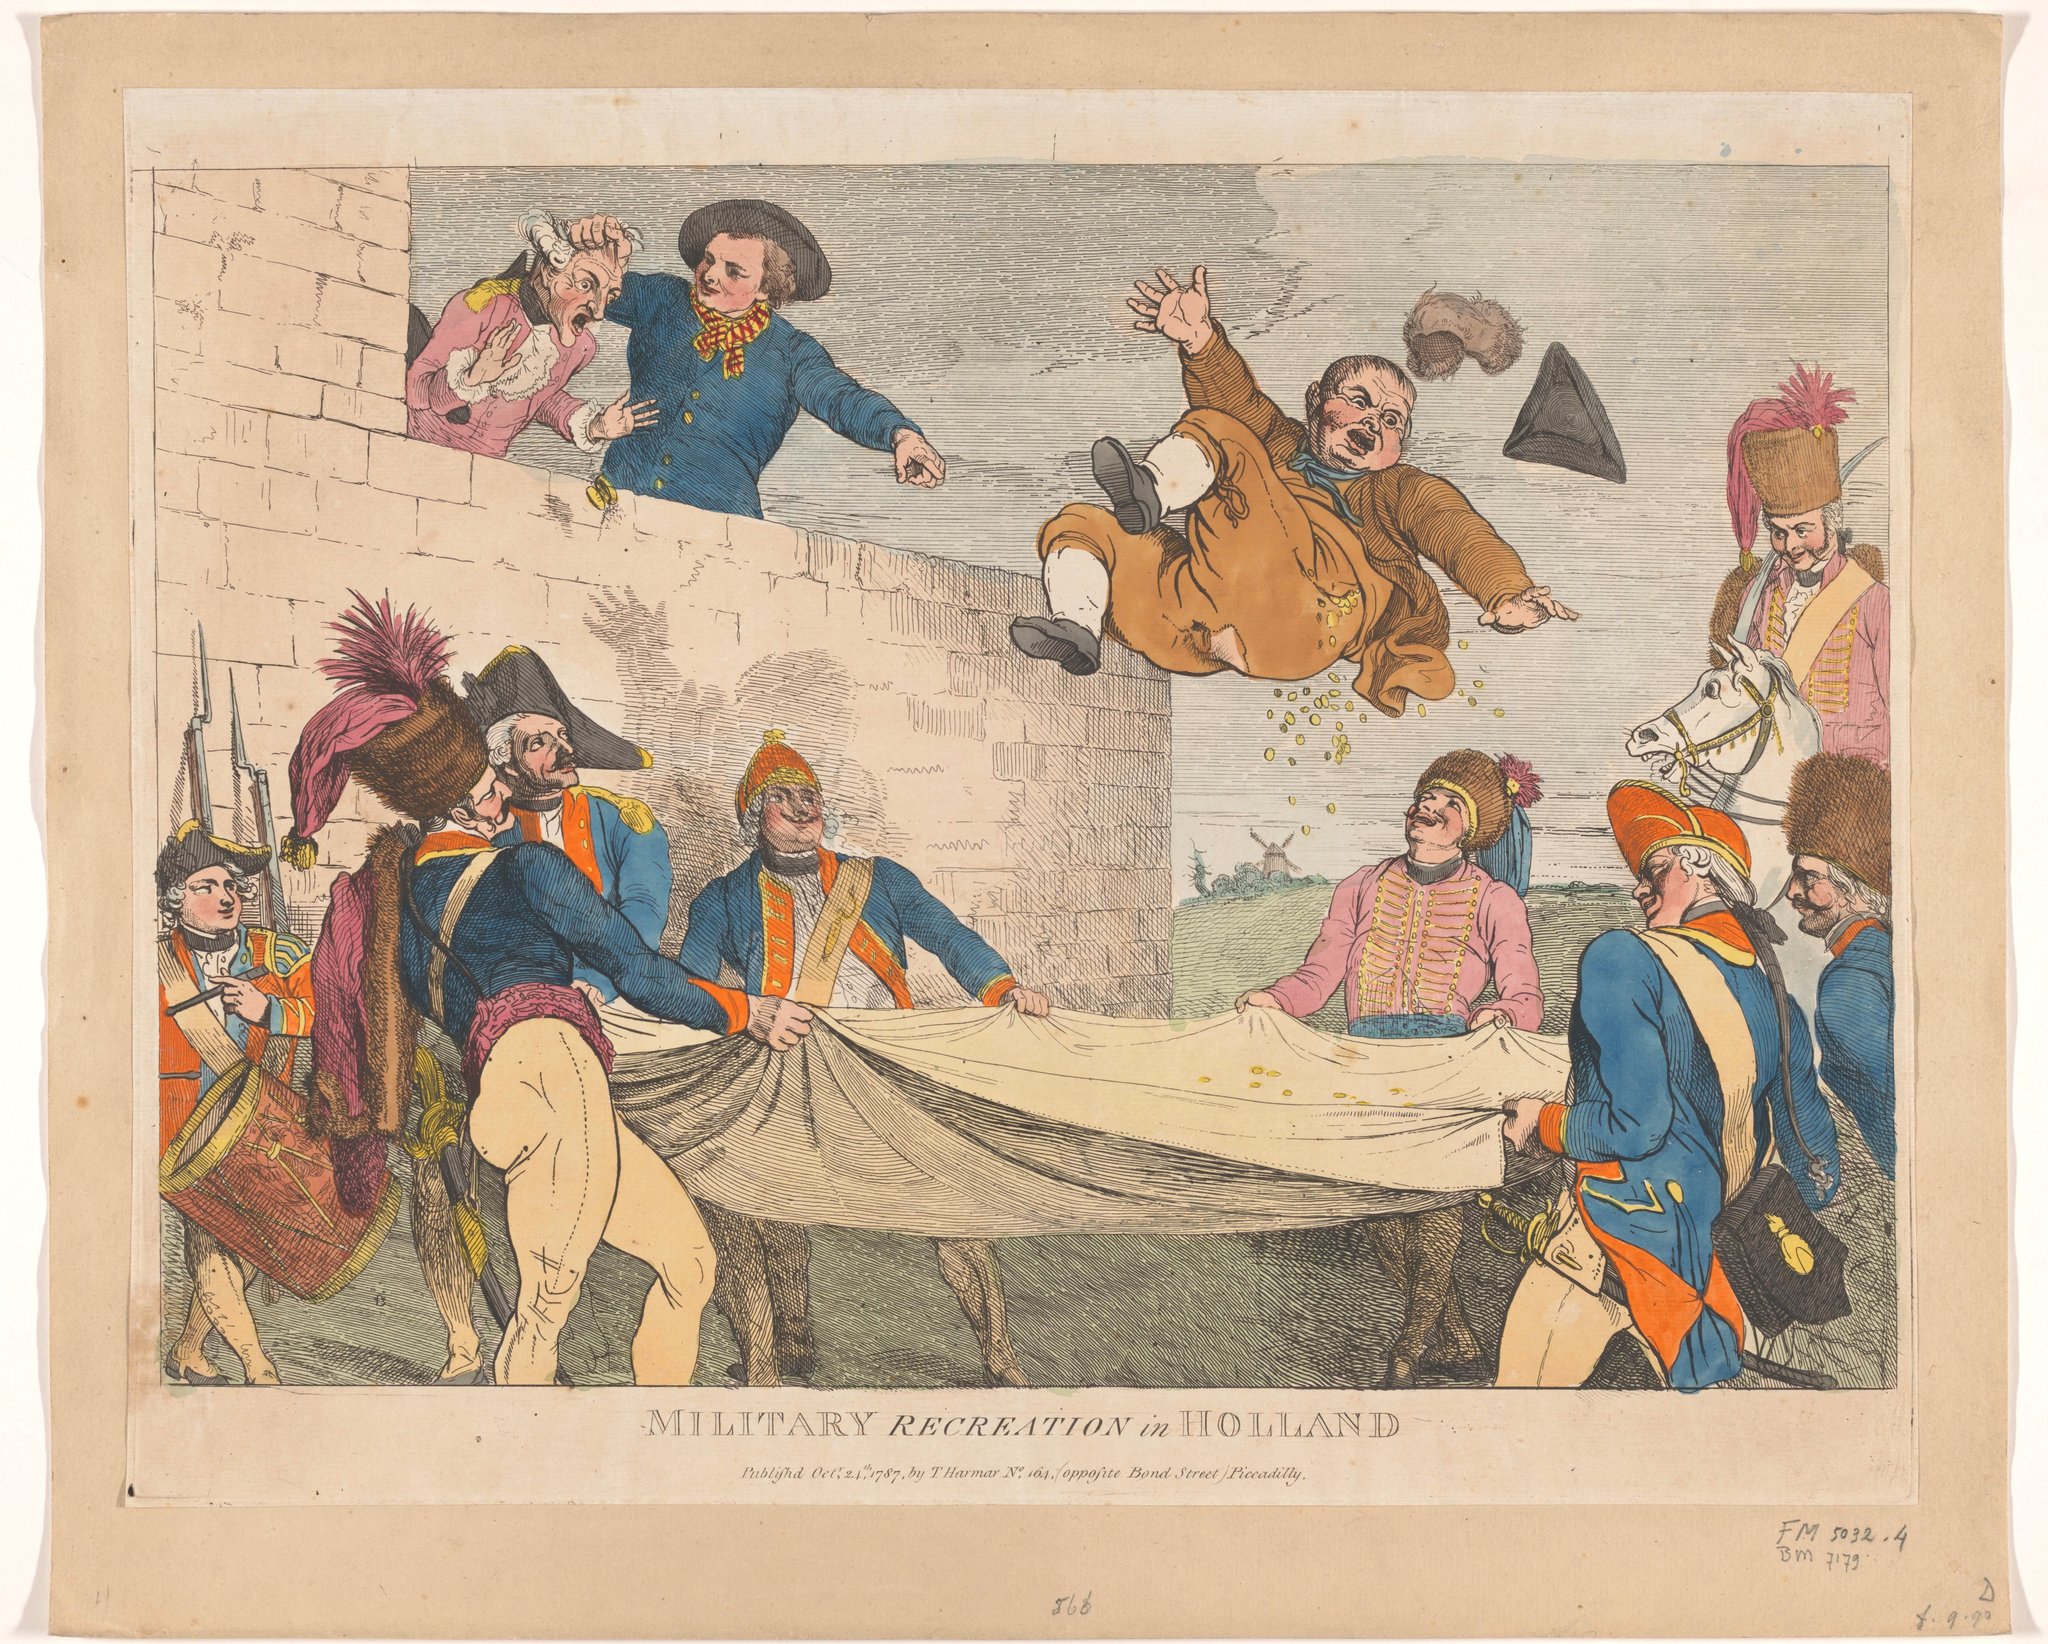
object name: cartoon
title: Military recreation in Holland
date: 1787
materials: paper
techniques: etching, hand coloring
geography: england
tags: grown-ups playing children's games, political caricatures and satires, patriots (1780-1795)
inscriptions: collector's mark: Lugt 2228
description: Een Hollandse patriot wordt door Pruisische soldaten in een deken in de lucht gegooid, waardoor de geldstukken uit zijn zakken vliegen. Linksboven dwingt een Engelse matroos de Fransman toe te kijken. Pastiche op een illustratie van een episode uit de avonturen van Don Quichot en Sancho Panza. Onderdeel van een groep van vier spotprenten op de patriotten ten tijde van de Pruisische inval in oktober 1787. De De originele versie met Engelse opschriften uitgegeven in Londen. Zie ook de pendant en het bijbehorende paar spotprenten.